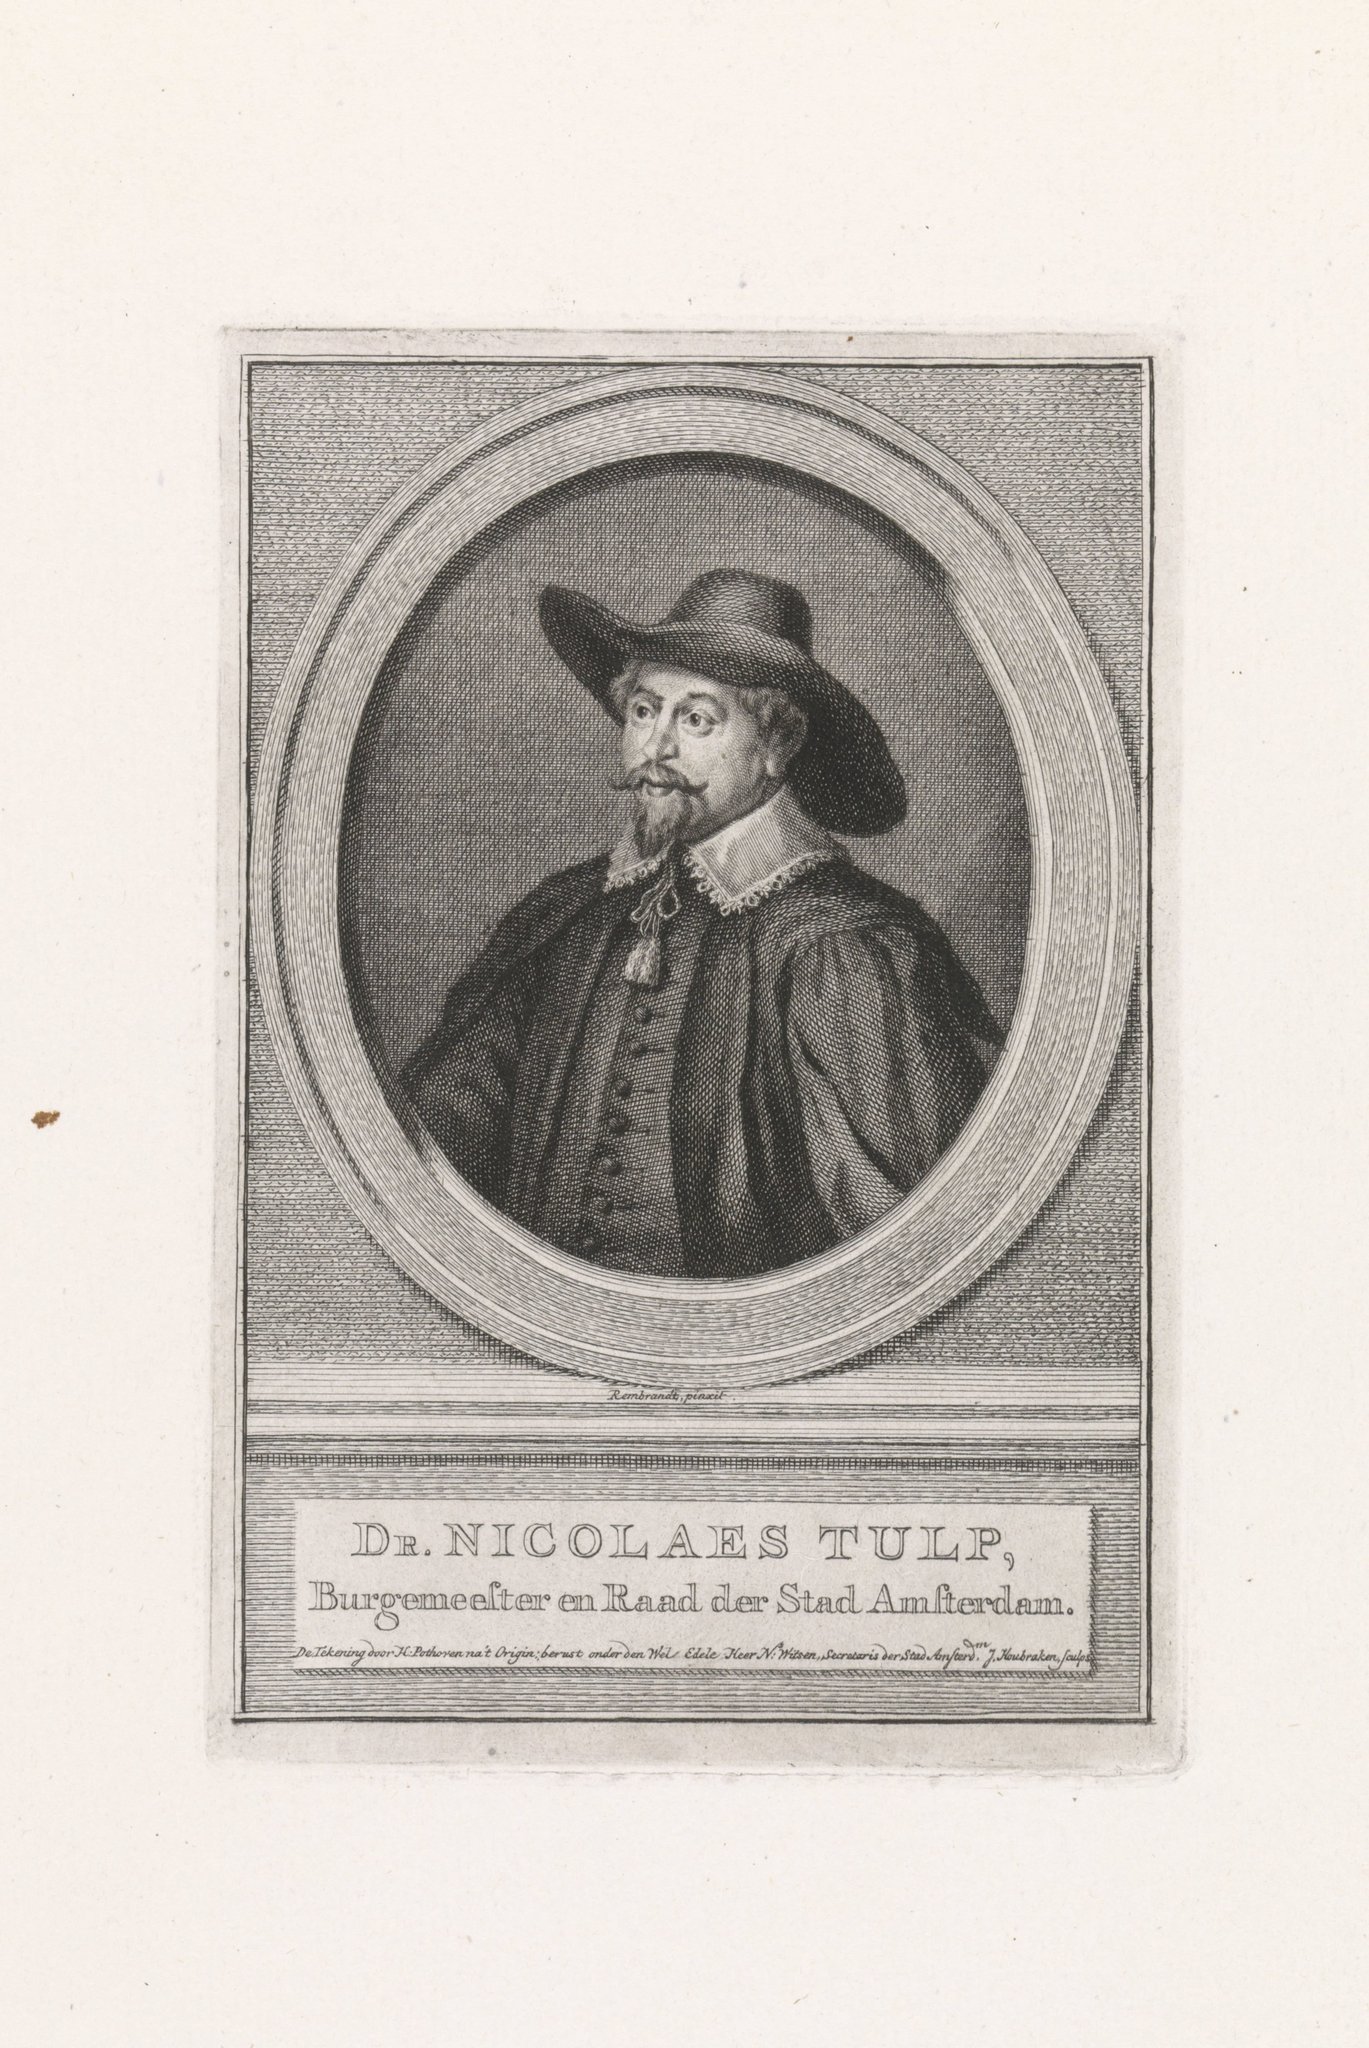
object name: print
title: Portret van Nicolaes Tulp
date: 1749-1780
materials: paper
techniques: engraving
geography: amsterdam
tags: the hague, mayor, historical persons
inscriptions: collector's mark: Lugt 2228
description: Deze prent is oorspronkelijk bedoeld als aanvulling op Jan Wagenaars ‘Vaderlandsche historie’* en was zo vanaf 1796 verkrijgbaar bij Johannes Allart te Amsterdam. Voor de advertentie waarin Allart de 60 portretten en 7 platen, allen gegraveerd door Houbraken, ter aanvulling op Wagenaars ‘Vaderlandsche historie’ aanbiedt, zie RP-P-OB-77.766. *Van dit werk zijn in de achttiende eeuw meerdere uitgaves verschenen, zoals: Wagenaar, Jan. Vaderlandsche historie, vervattende de geschiedenissen der Vereenigde Nederlanden (…). 21 delen. Amsterdam: Isaak Tirion, 1749-1759. Wagenaar, Jan. Vaderlandsche historie, vervattende de geschiedenissen der nu Vereenigde Nederlanden (…). 21 delen. Amsterdam: weduwe Isaak Tirion, 1770. Wagenaar, Jan. Vaderlandsche historie, vervattende de geschiedenissen der nu Vereenigde Nederlanden (…). 21 delen. Amsterdam, Leiden, Dordrecht en Harlingen: P. Schouten e.a., 1782. Wagenaar, Jan. Vaderlandsche historie, vervattende de geschiedenissen der nu Vereenigde Nederlanden (…). 21 delen. Amsterdam: Johannes Allart, 1790-1796.